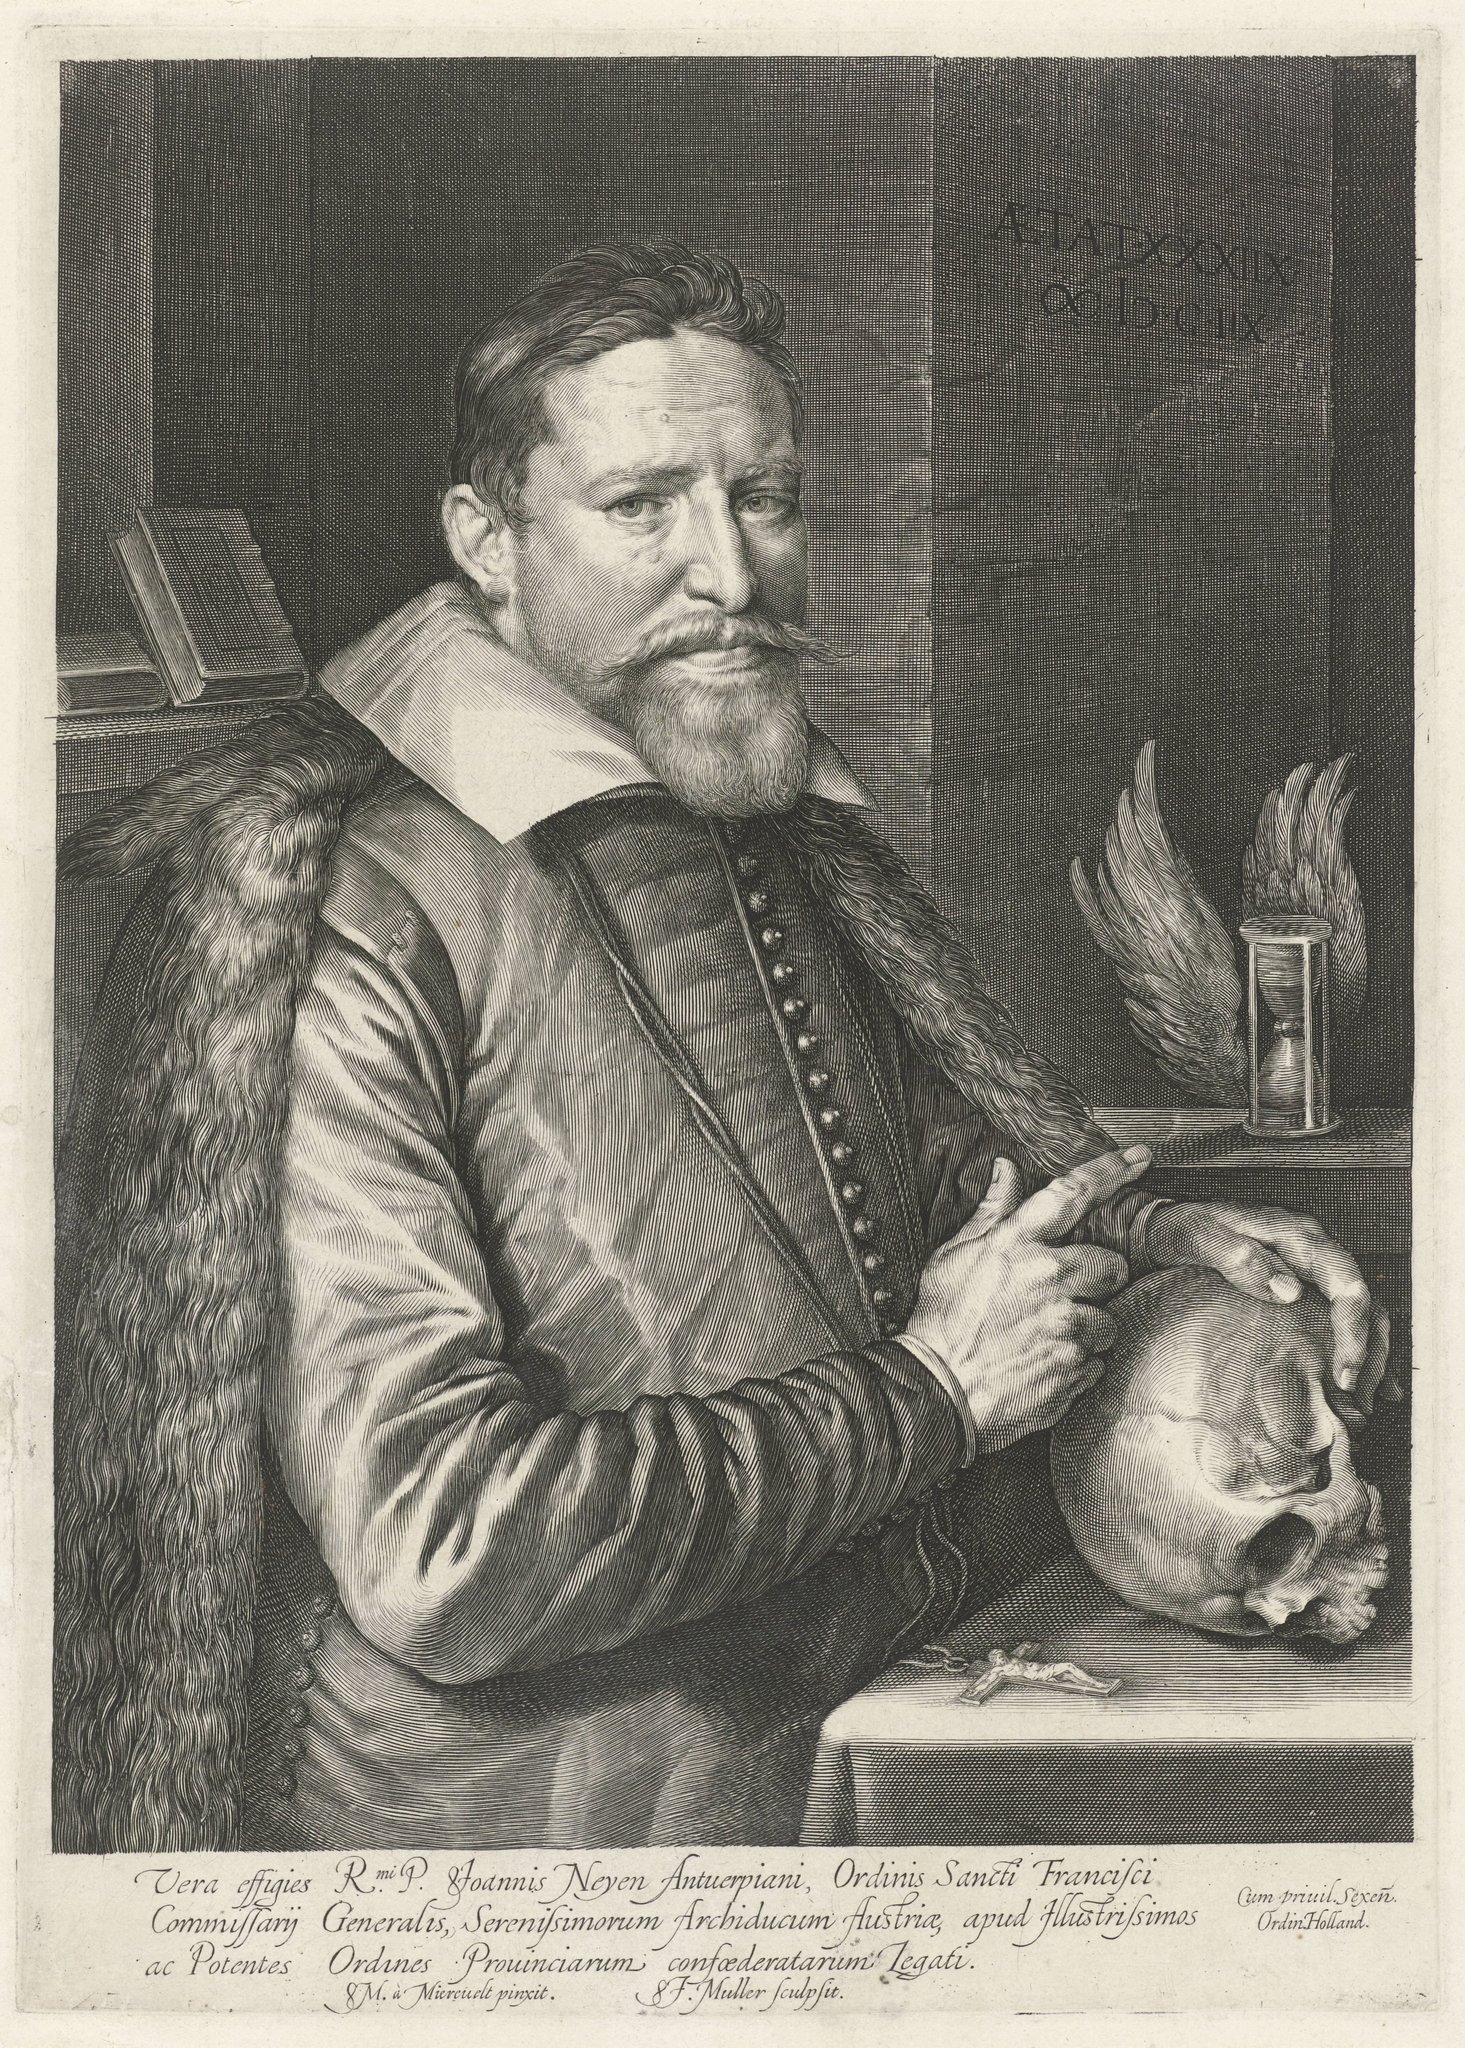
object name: print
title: Portret van Jan Neyen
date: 1608-1609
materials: paper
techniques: engraving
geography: amsterdam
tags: antwerp, spain, hourglass, death's head, skull (symbol of death)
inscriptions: collector's mark: Lugt 240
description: Portret van Jan Neyen, minderbroeder en onderhandelaar met de Staten Generaal over het Twaalfjarig Bestand. Hij laat een hand rusten op een schedel en wijst met de ander naar een gevleugelde zandloper. Op tafel ligt een crucifix.